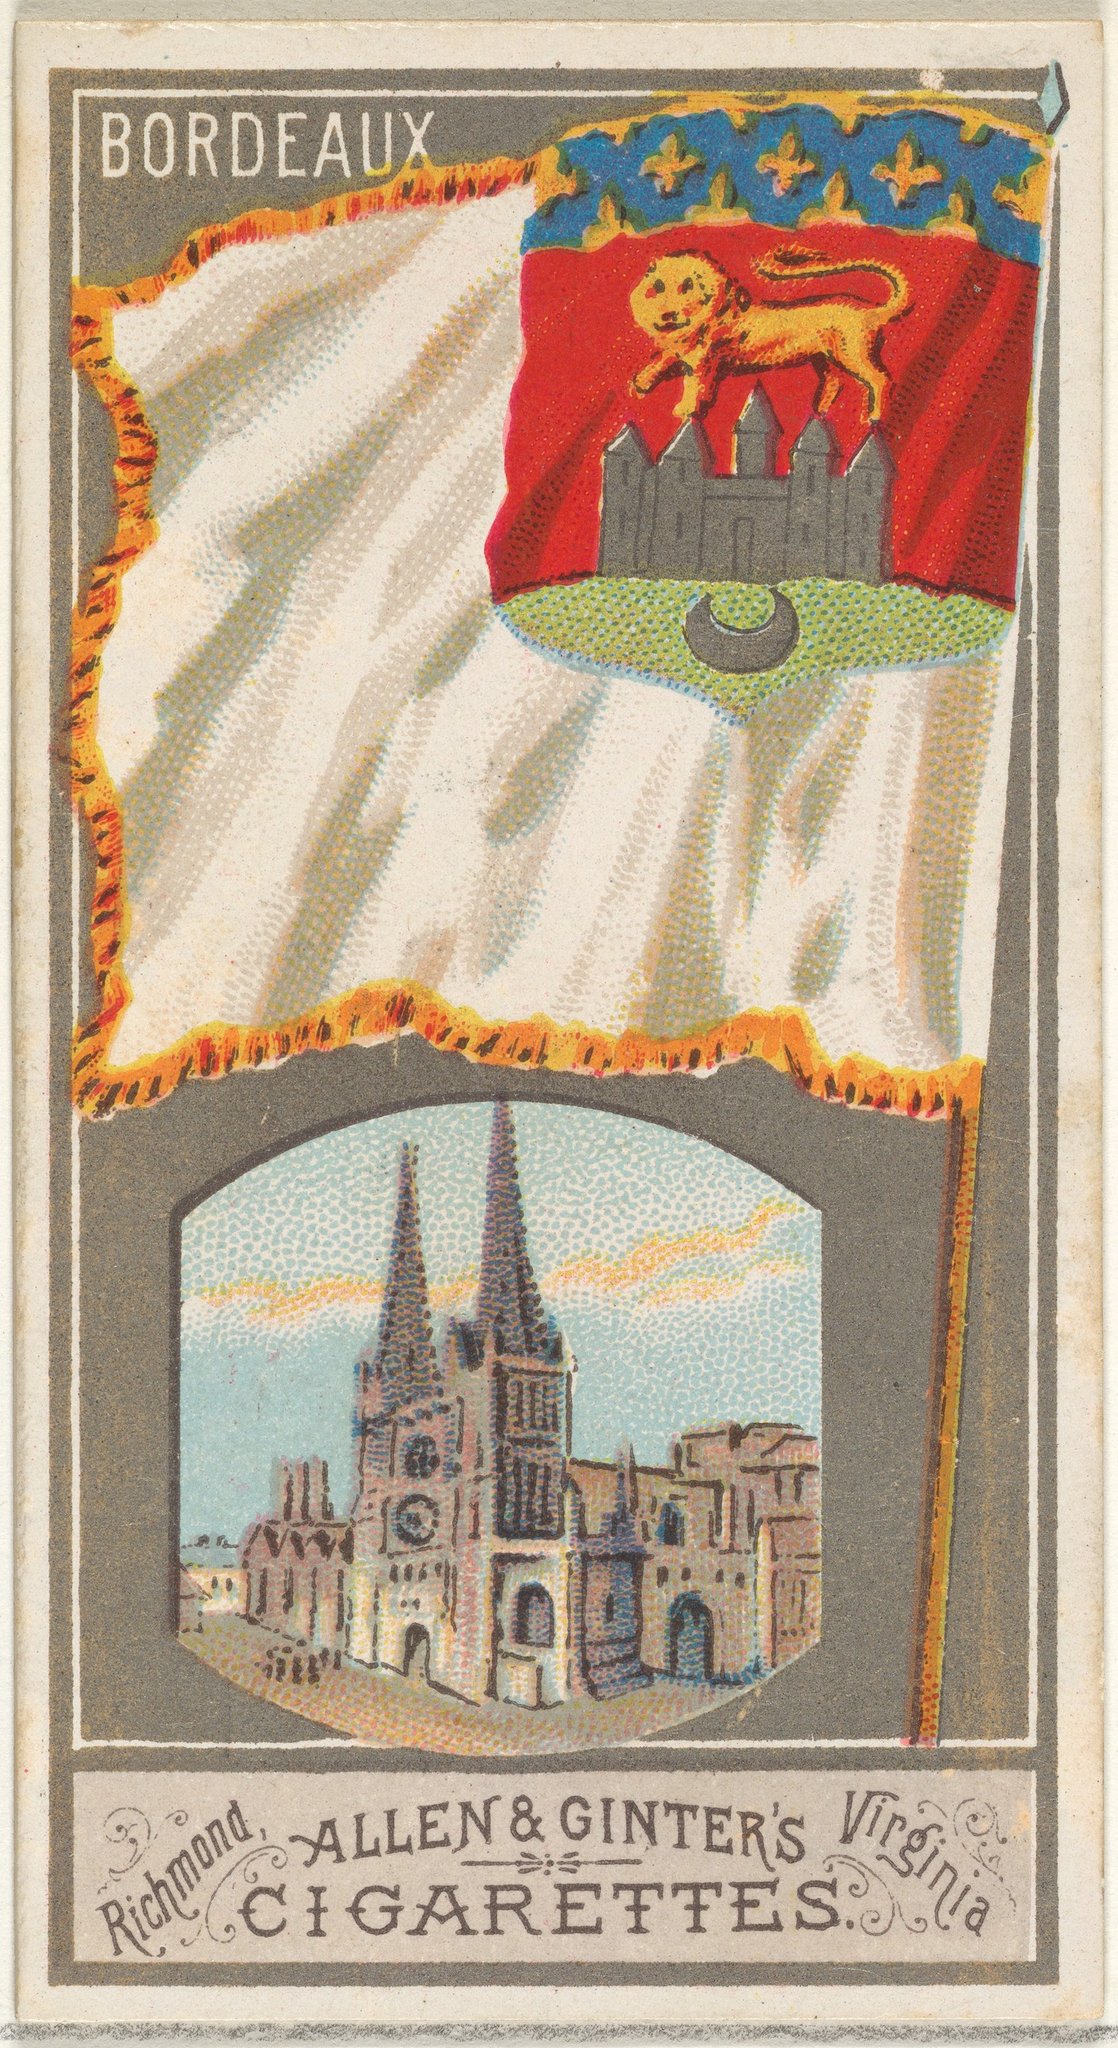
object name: print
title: Bordeaux, from the City Flags series (N6) for Allen & Ginter Cigarettes Brands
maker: allen & ginter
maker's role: publisher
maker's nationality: american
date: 1887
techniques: color lithograph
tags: coat of arms,flags